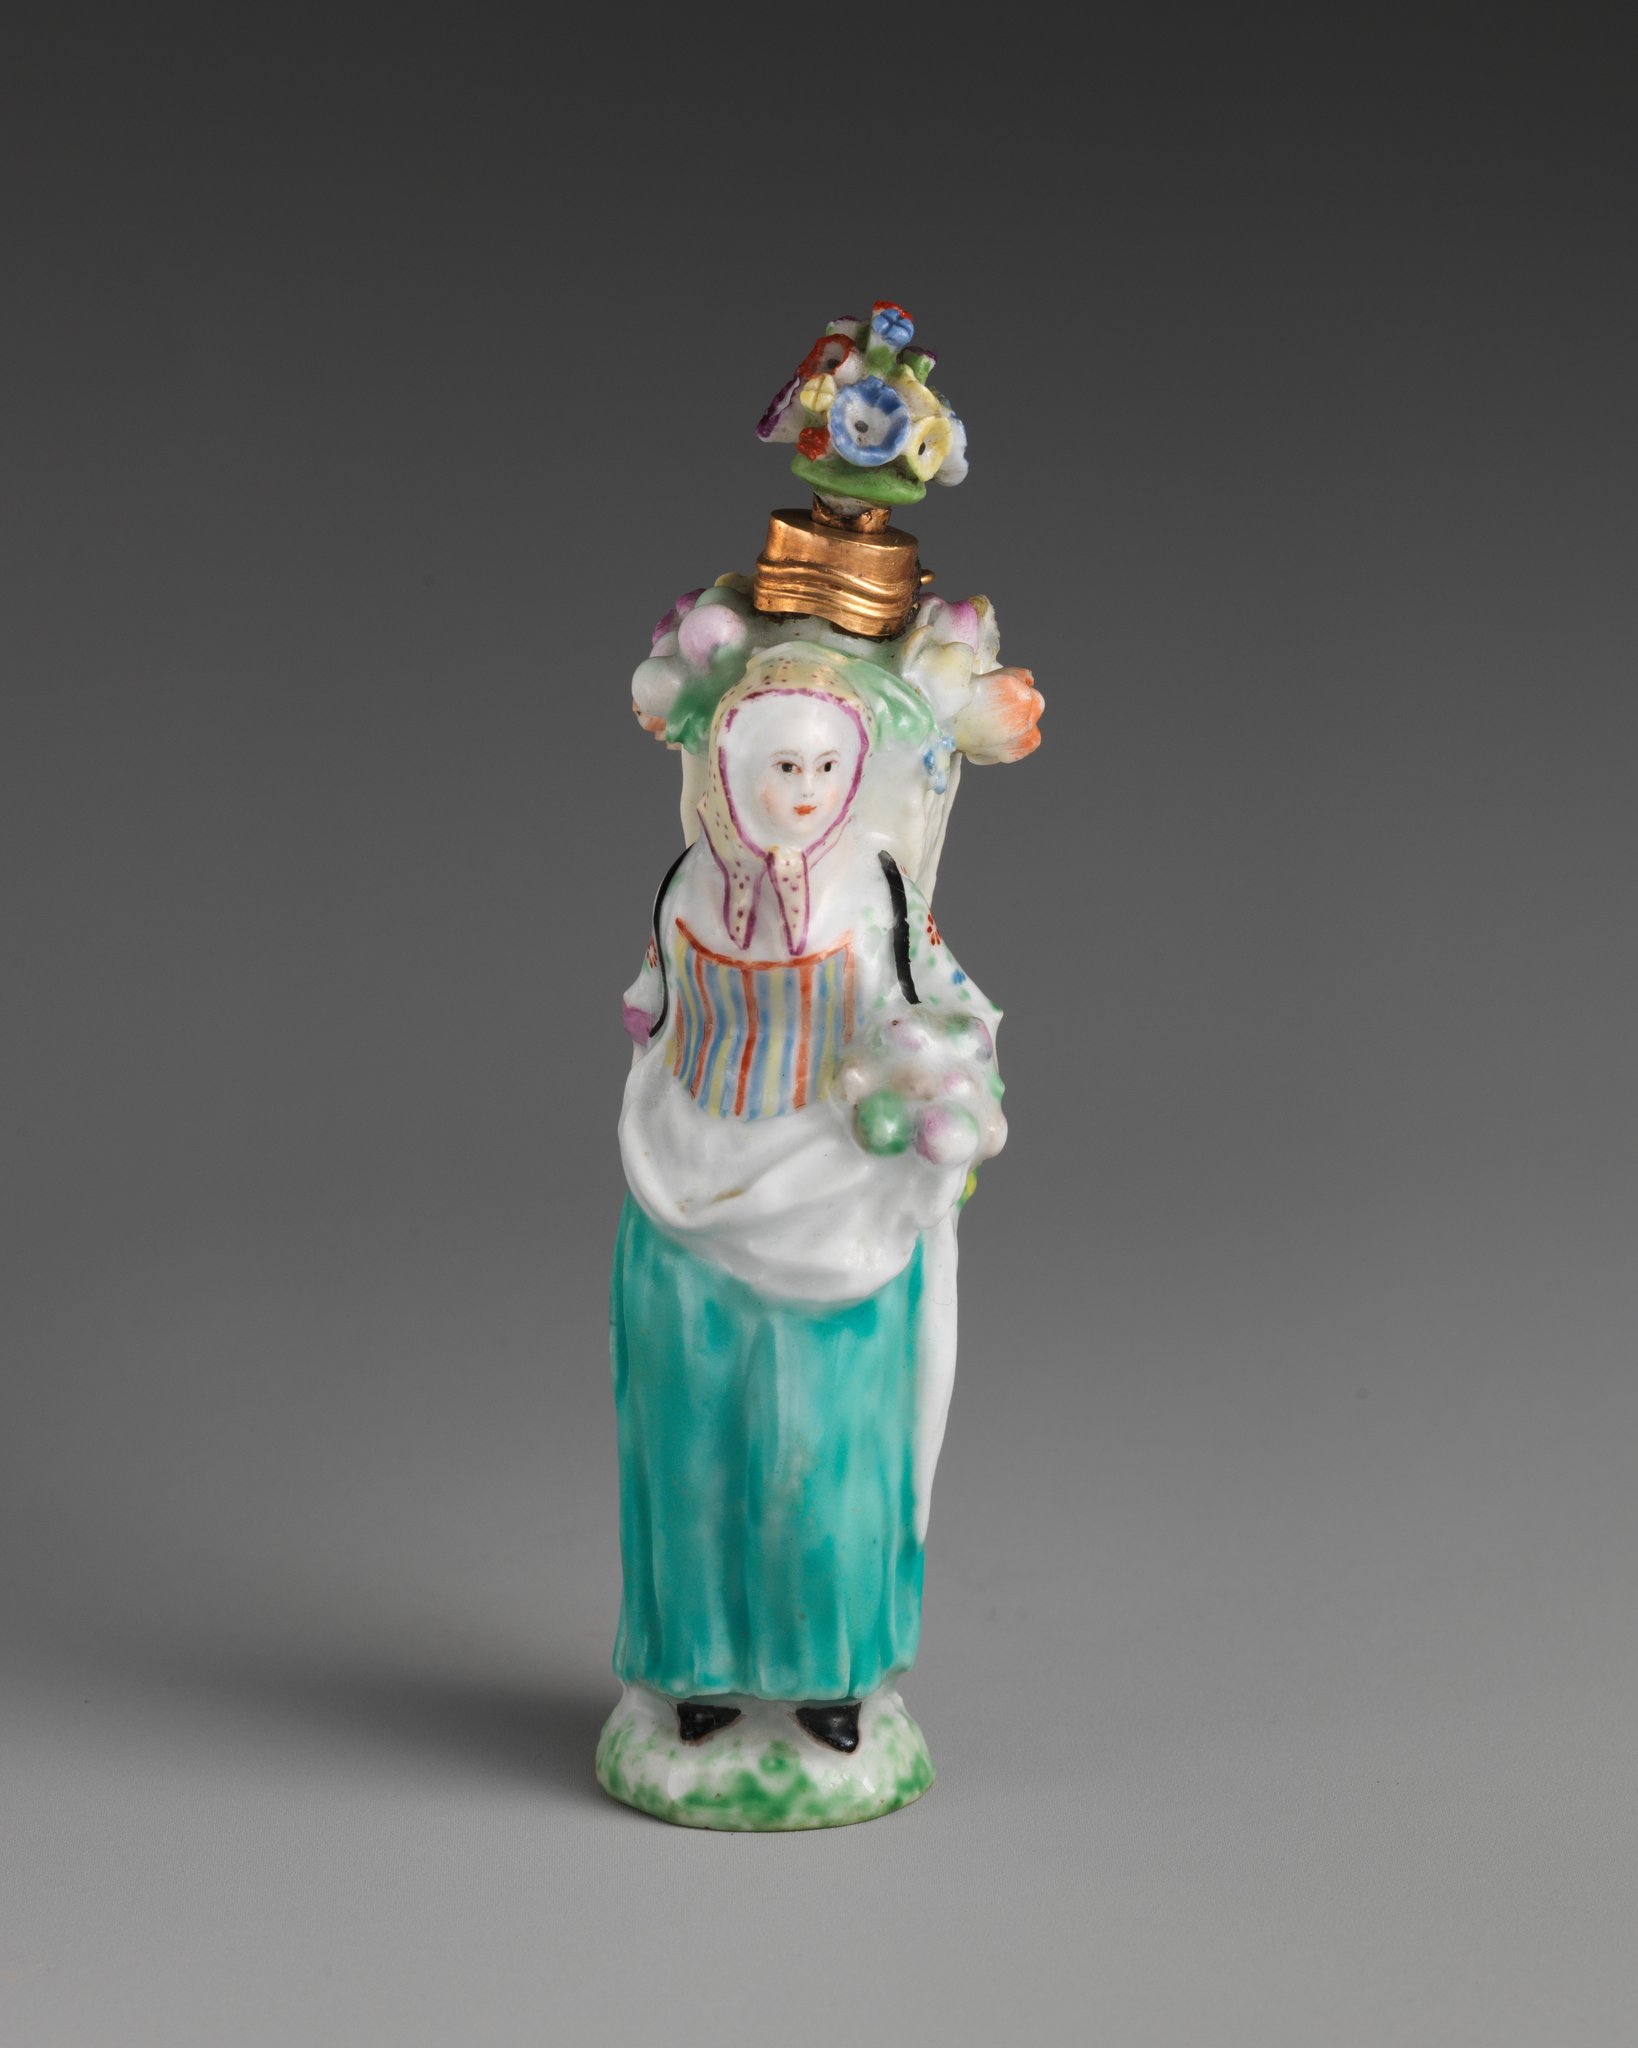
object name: toy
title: Girl gardener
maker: chelsea porcelain manufactory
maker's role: factory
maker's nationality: british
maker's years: 1744-1784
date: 1760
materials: soft paste porcelain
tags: girls,flowers,gardeners